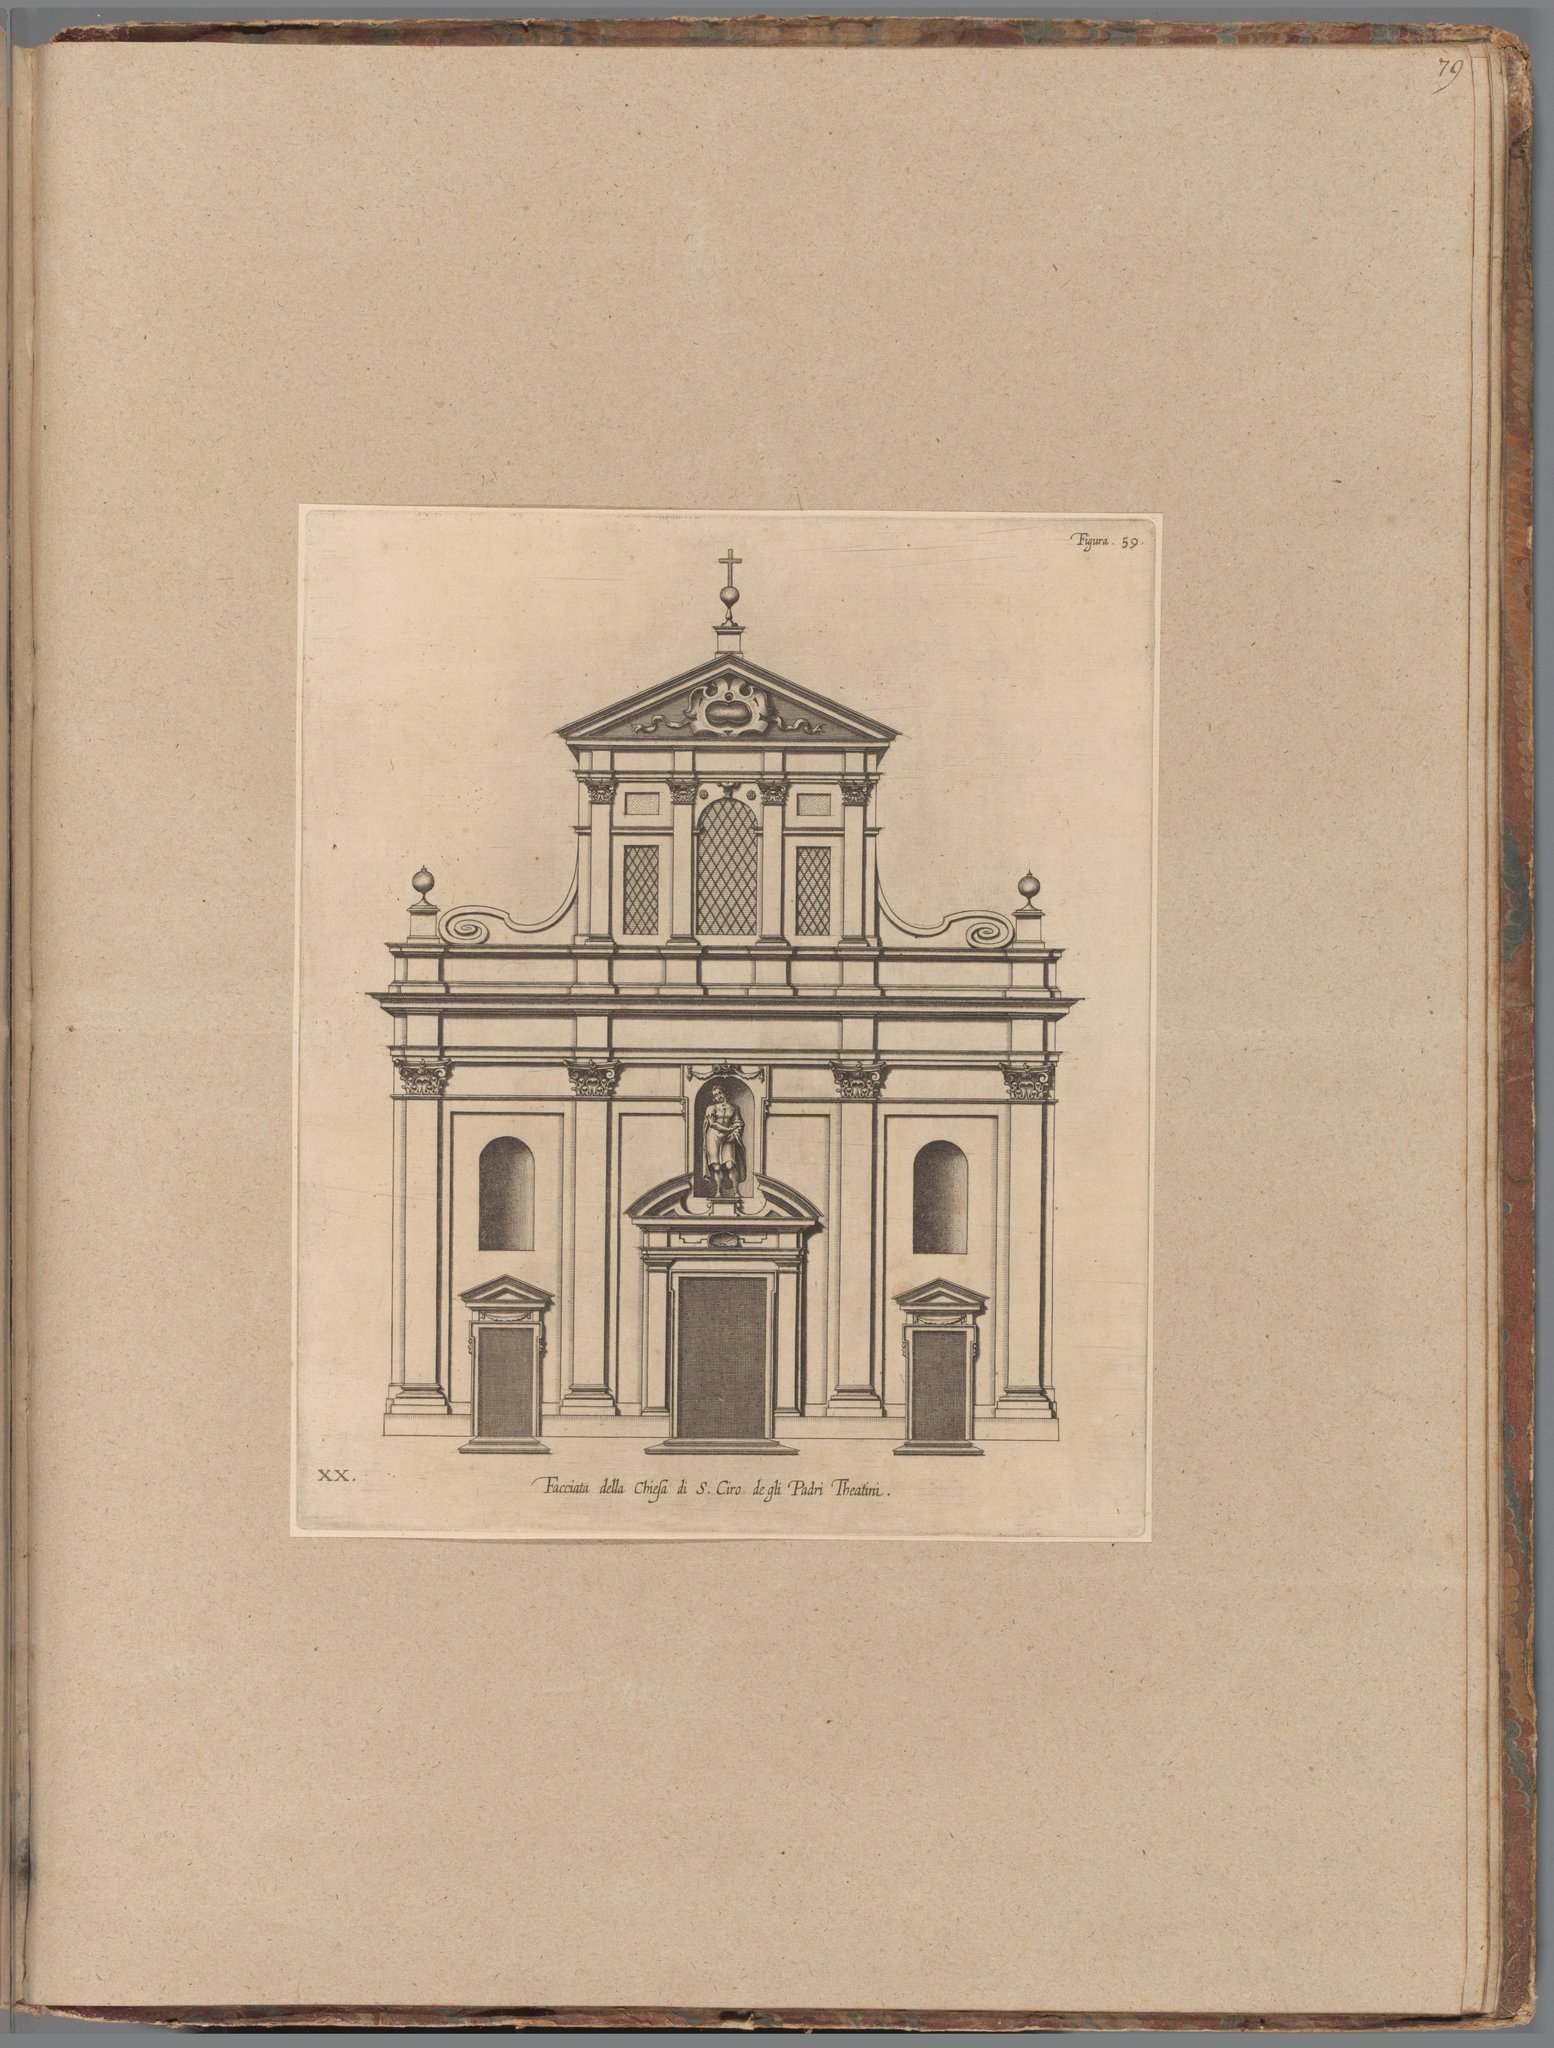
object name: album leaf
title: Facciata de la chiesa de S. Ciro degli Padri Theatini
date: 1622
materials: paper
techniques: engraving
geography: antwerp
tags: parts of church exterior and annexes: façade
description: Deze prent maakt deel uit van een album.